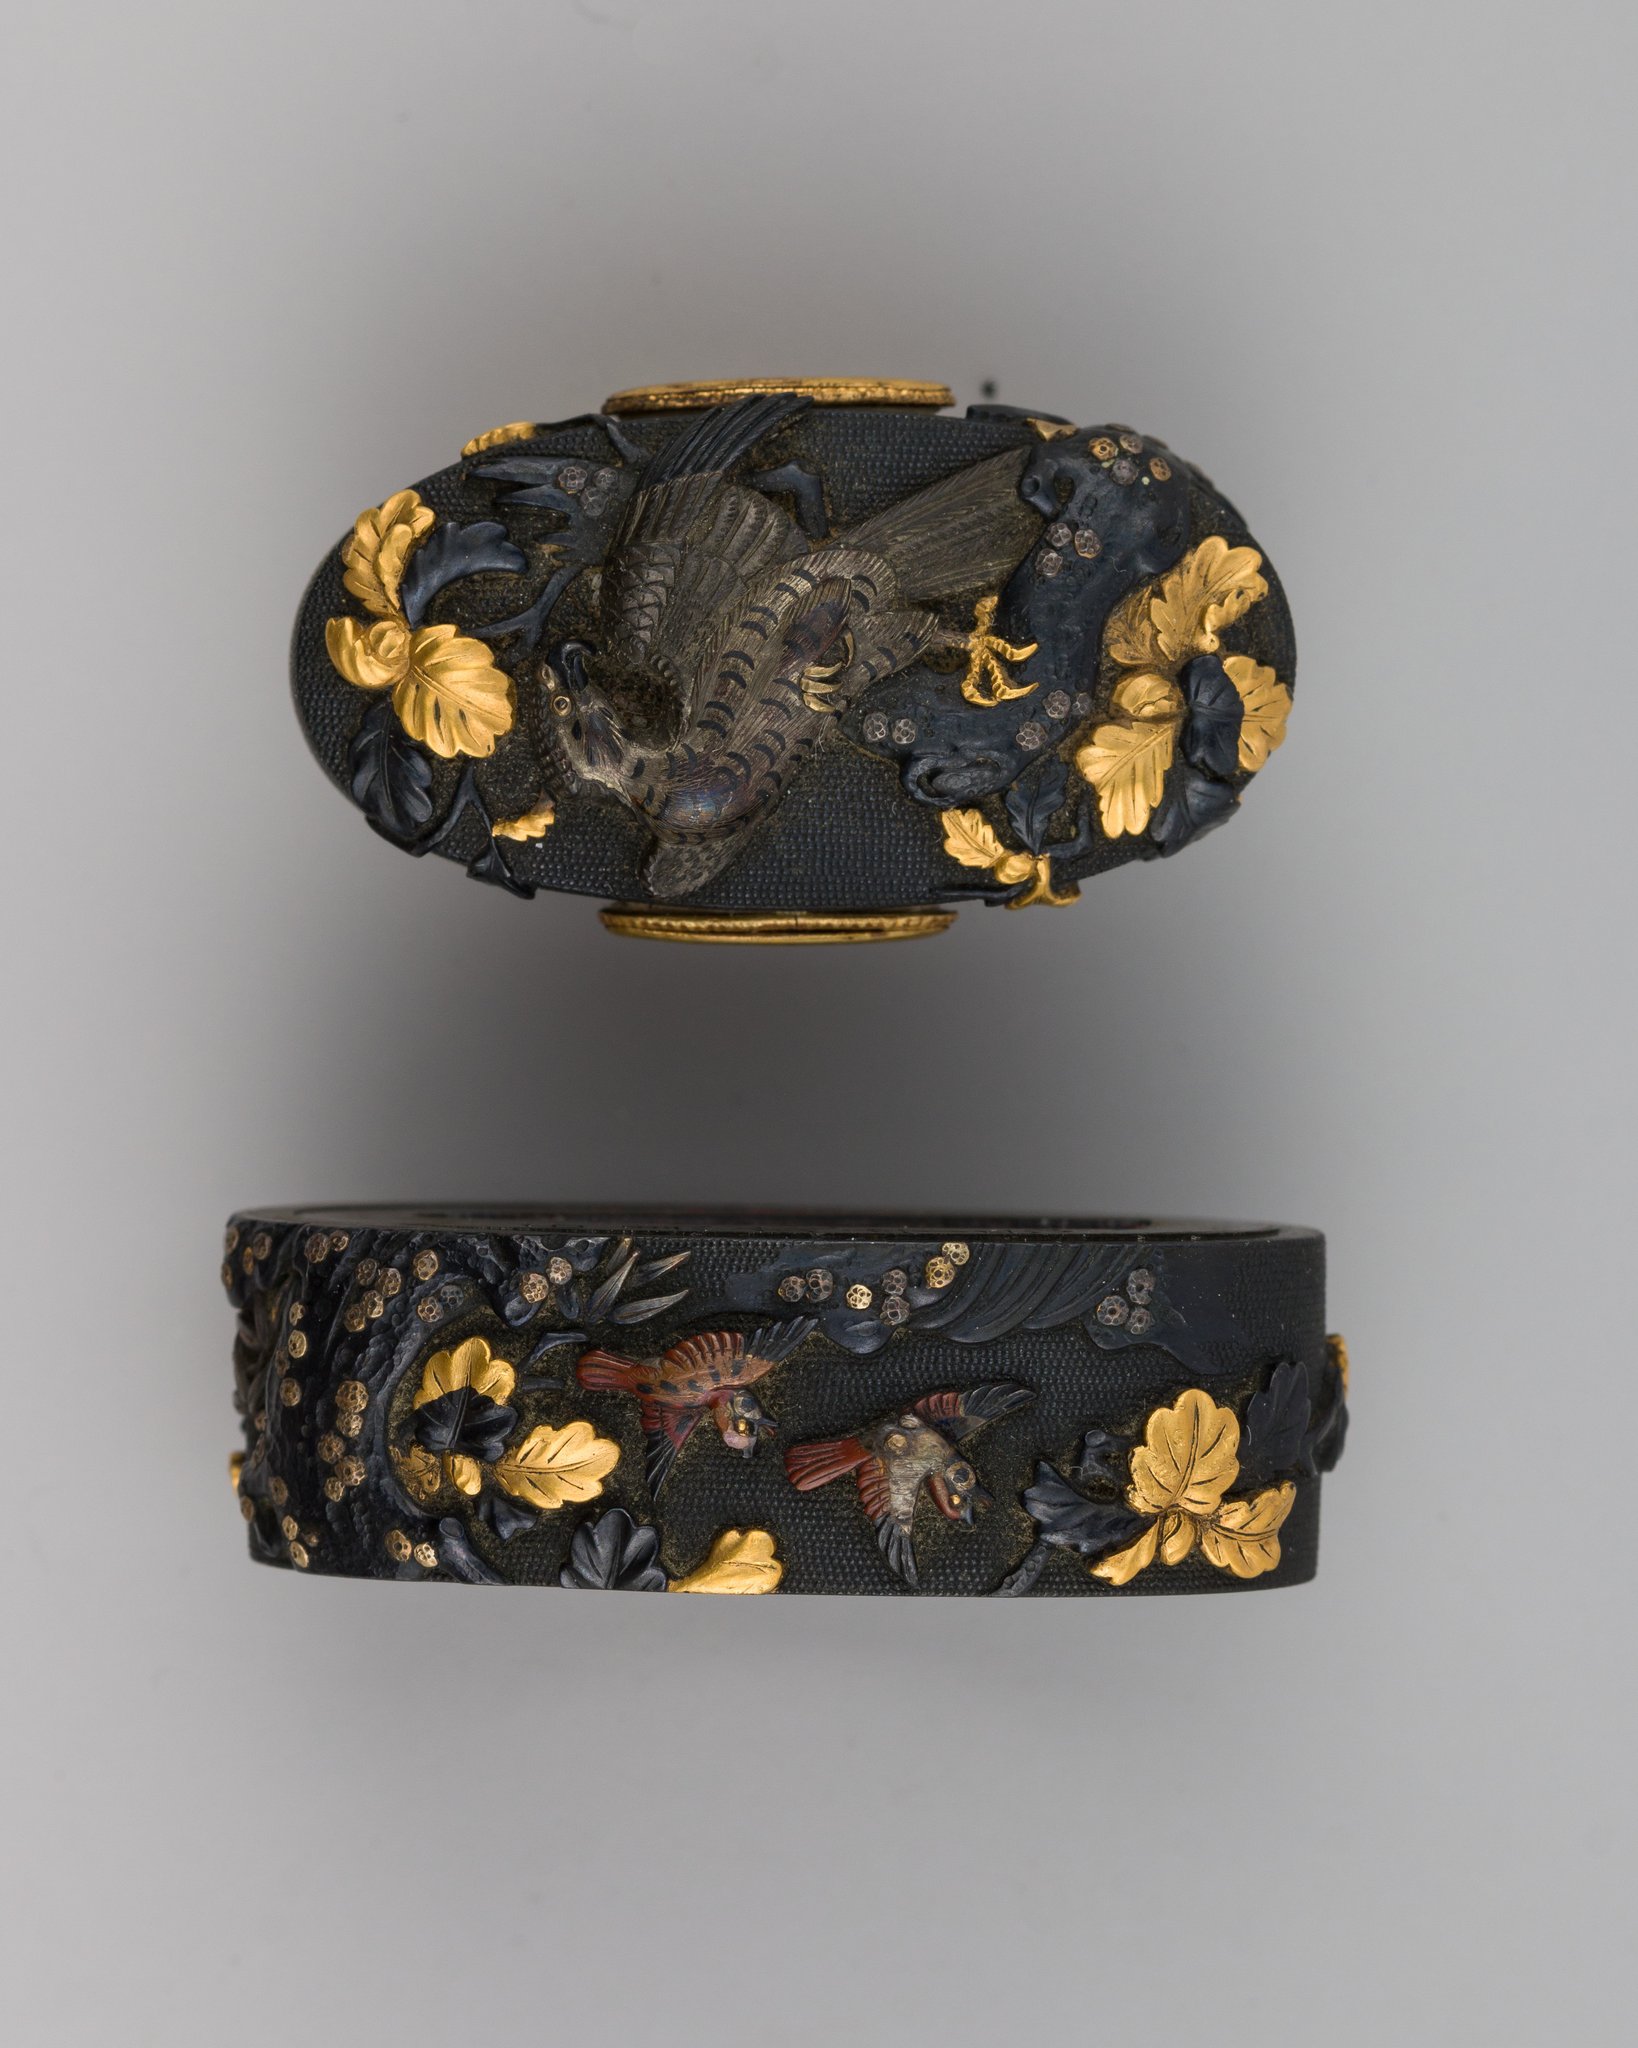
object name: sword hilt collar and pommel fuchigashira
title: Sword-Hilt Collar and Pommel (Fuchigashira)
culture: japanese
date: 1801-1900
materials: gold alloy, gold, silver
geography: japan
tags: birds,leaves